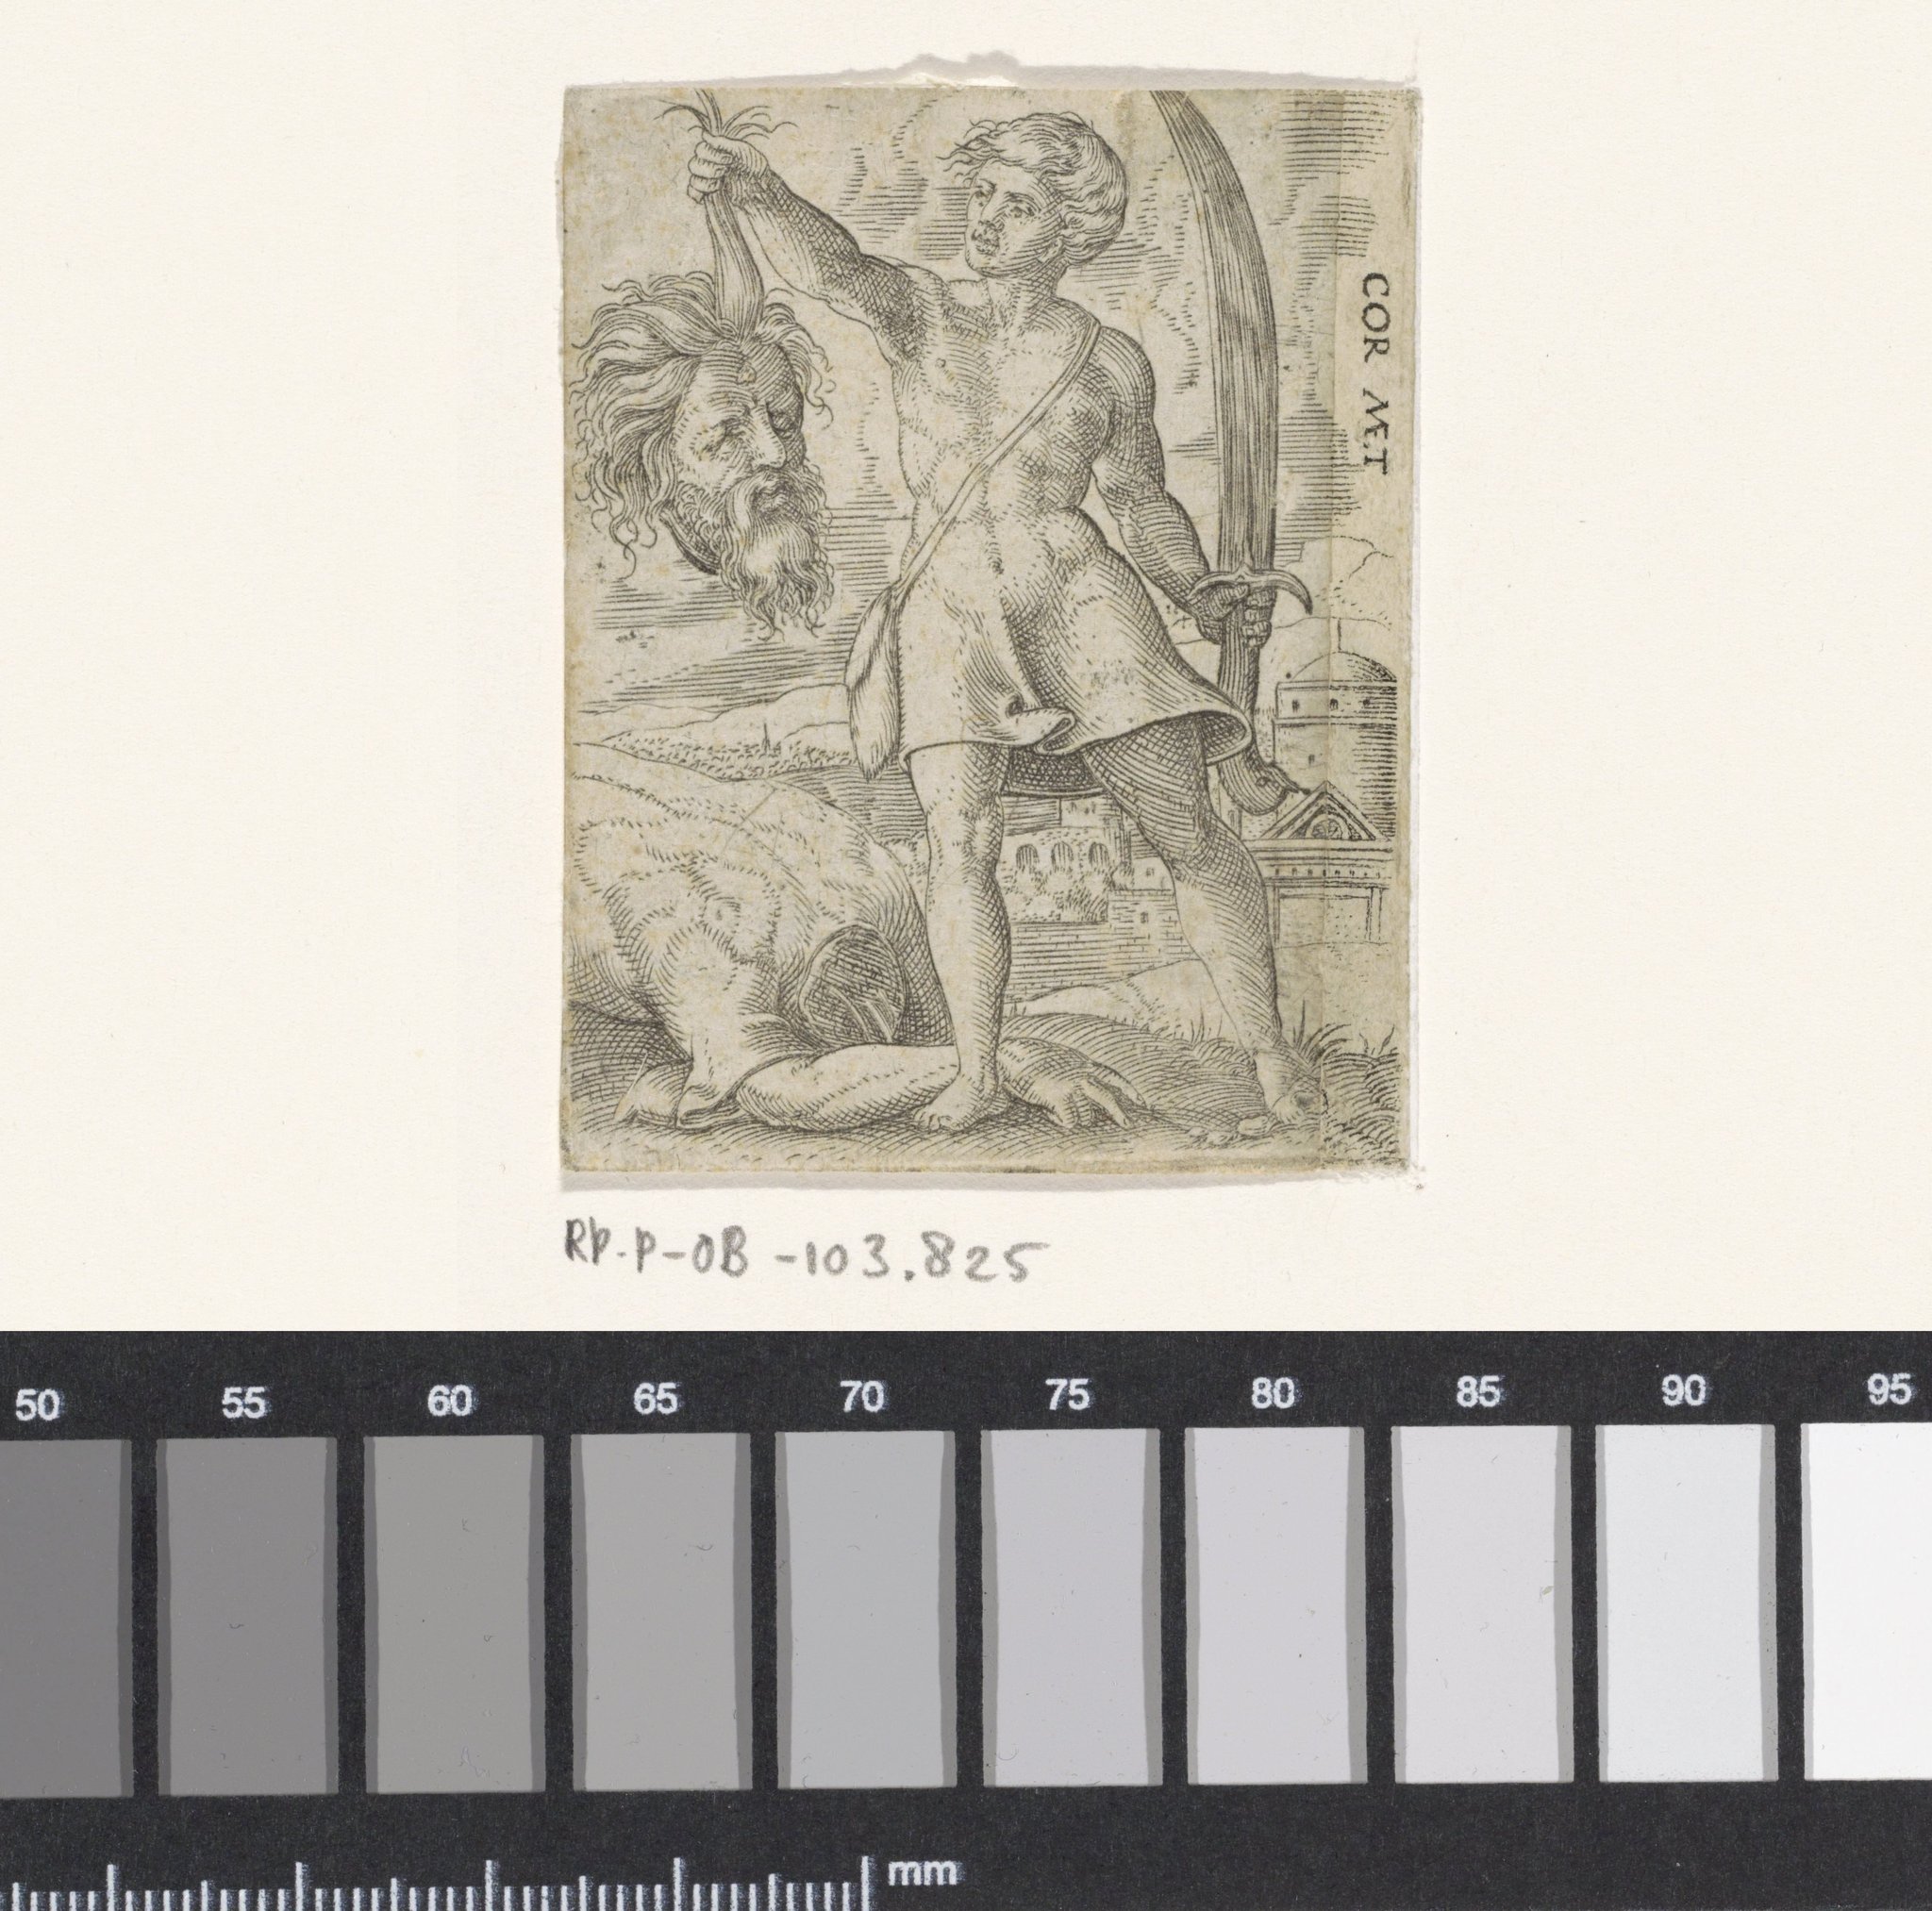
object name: print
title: David met het hoofd van Goliat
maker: cornelis massijs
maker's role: painter, print maker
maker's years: 1510-1557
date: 1539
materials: paper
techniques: engraving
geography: antwerp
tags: david with goliath's head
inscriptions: collector's mark: Lugt 2228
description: David houdt het afgehouwen hoofd van Goliat in zijn ene hand en het zwaard in de andere hand. Op de grond ligt het lichaam van Goliat.